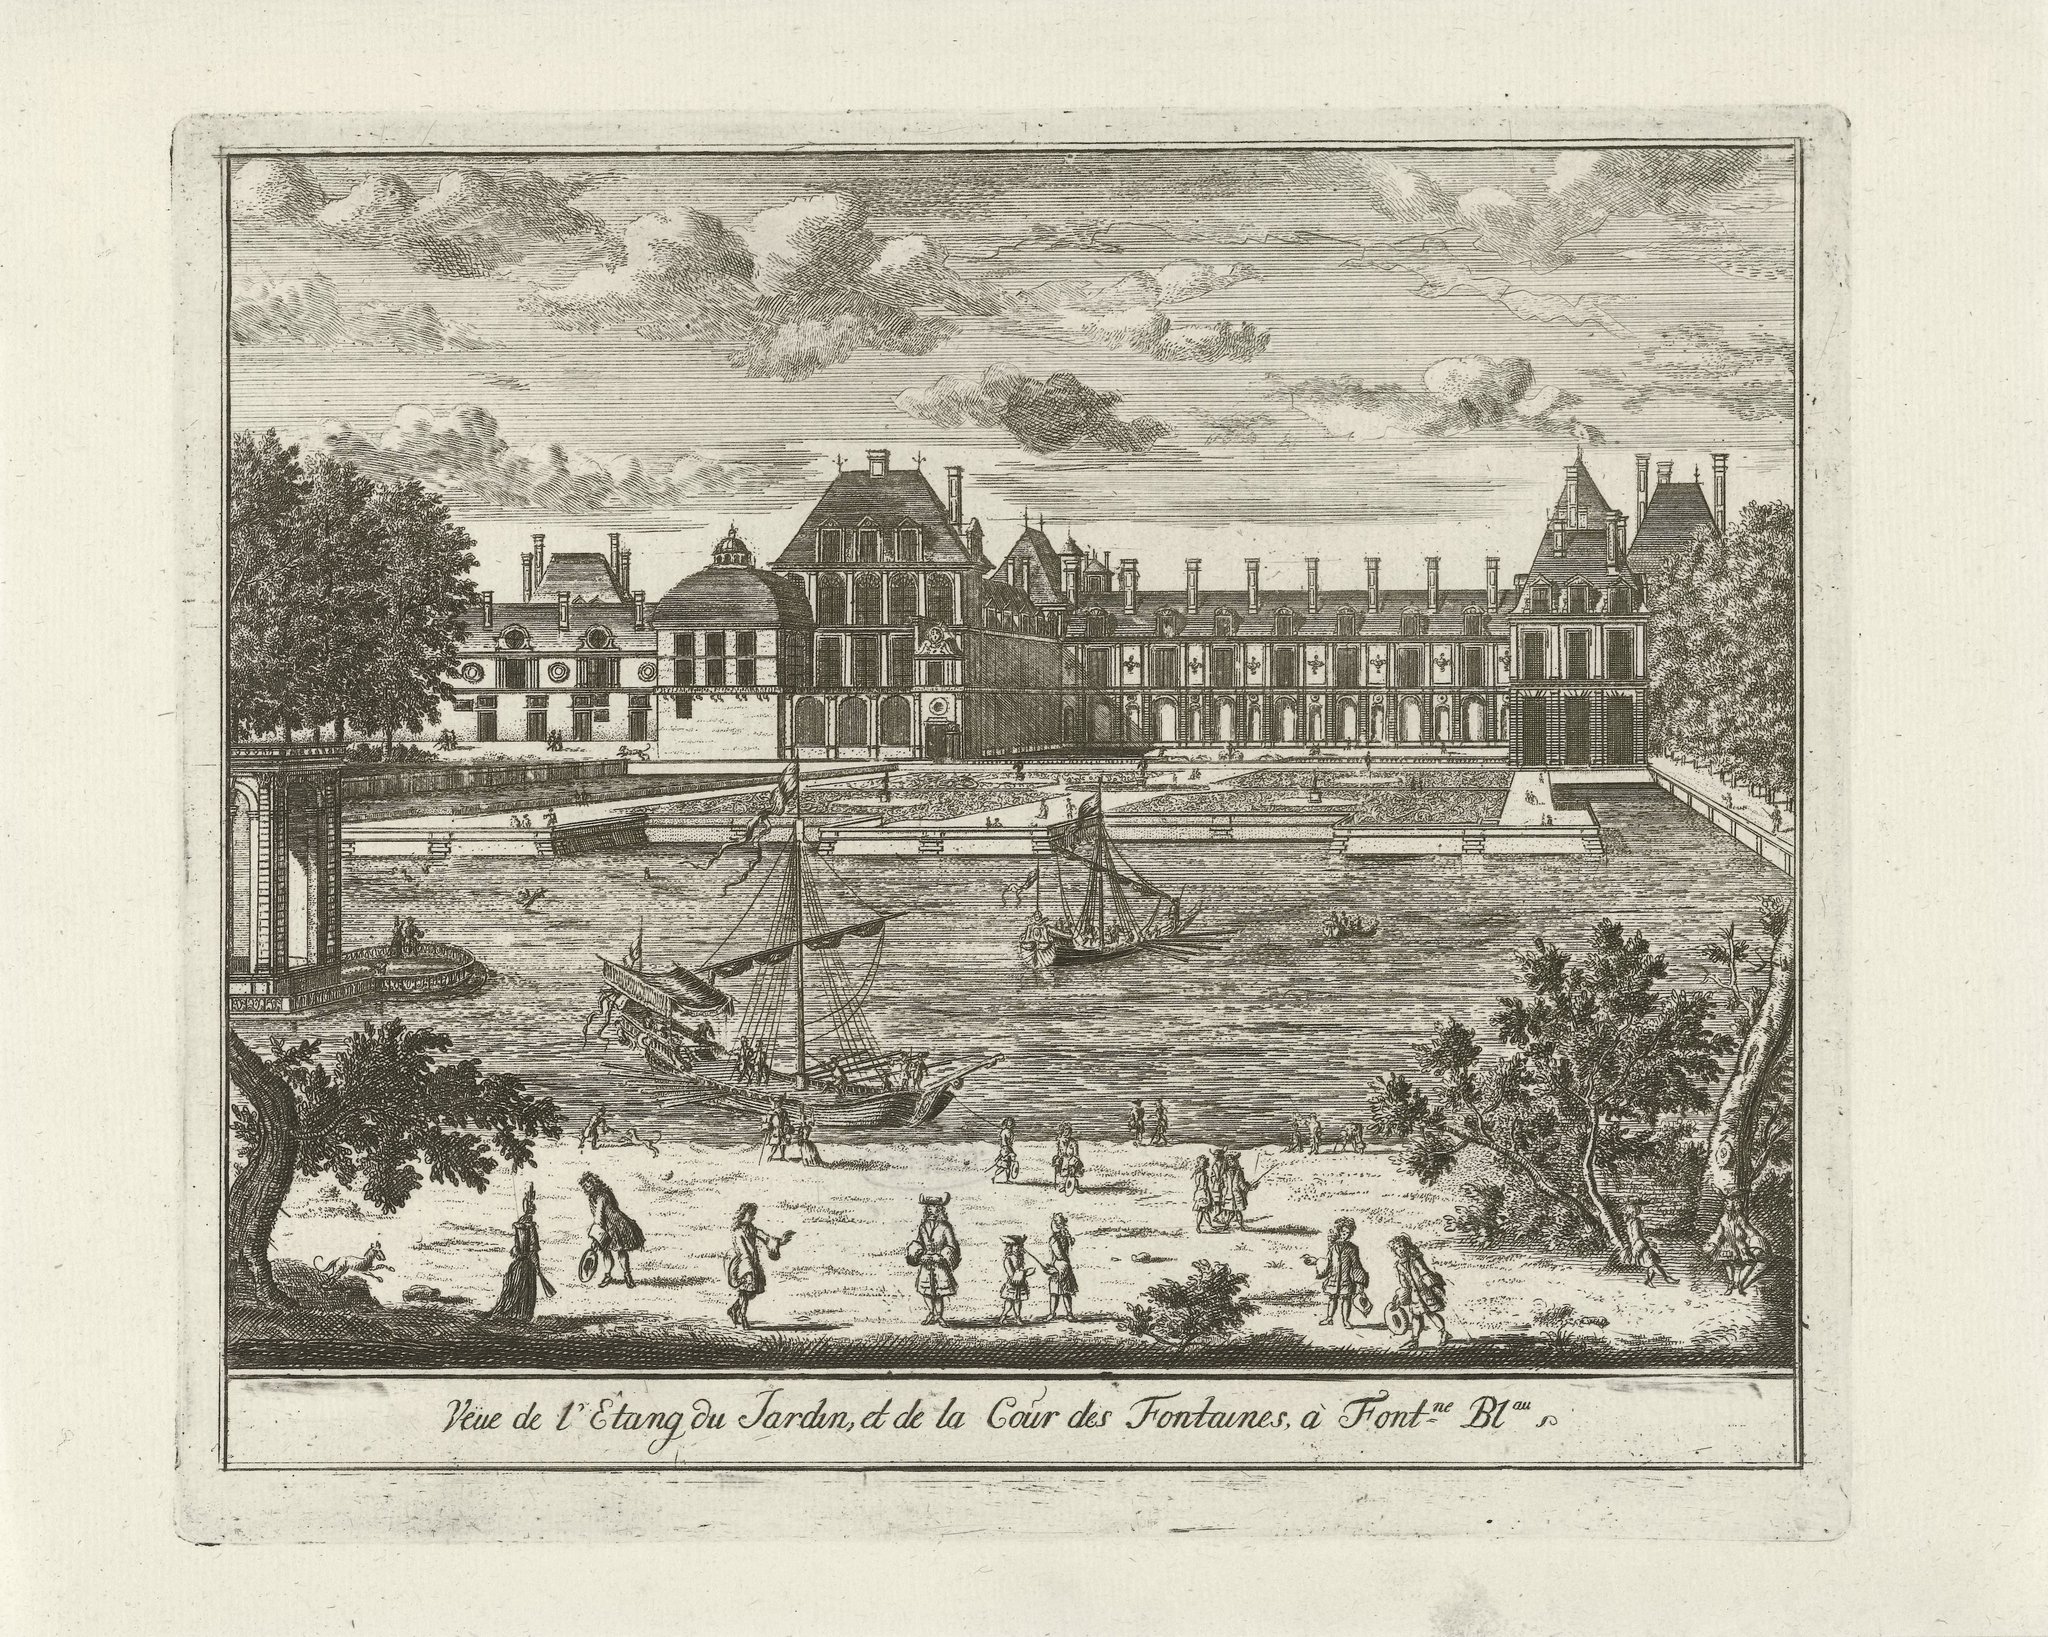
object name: print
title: Gezicht op de Cour de la Fontaine van het paleis van Fontainebleau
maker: jan lamsvelt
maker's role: print maker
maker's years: 1674-1743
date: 1726-1743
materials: paper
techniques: etching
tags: palace, courtyard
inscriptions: collector's mark: Lugt 2228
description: Deze prent is tevens opgenomen in deel III van het prentwerk: Les Forces de l'Europe, Asie, Afrique et Amerique ... Comme aussi les Cartes des Côtes de France et d'Espagne (1726). Dit is het eerste deel met 238 met de hand genummerde platen van vermaarde sterke steden en vestingen in het kader van de Spaanse Successieoorlog 1701-1713. Voor het merendeel zijn deze platen gekopieerd naar de anonieme Franse platen van vermaarde sterke steden en vestingen: in Les forces de l'Europe en in: Le theatre de la guerre, dans les Pays-Bas, beide oorspronkelijk uitgegeven door Nicolas de Fer te Parijs (1693-1697) in het kader van de Negenjarige Oorlog.